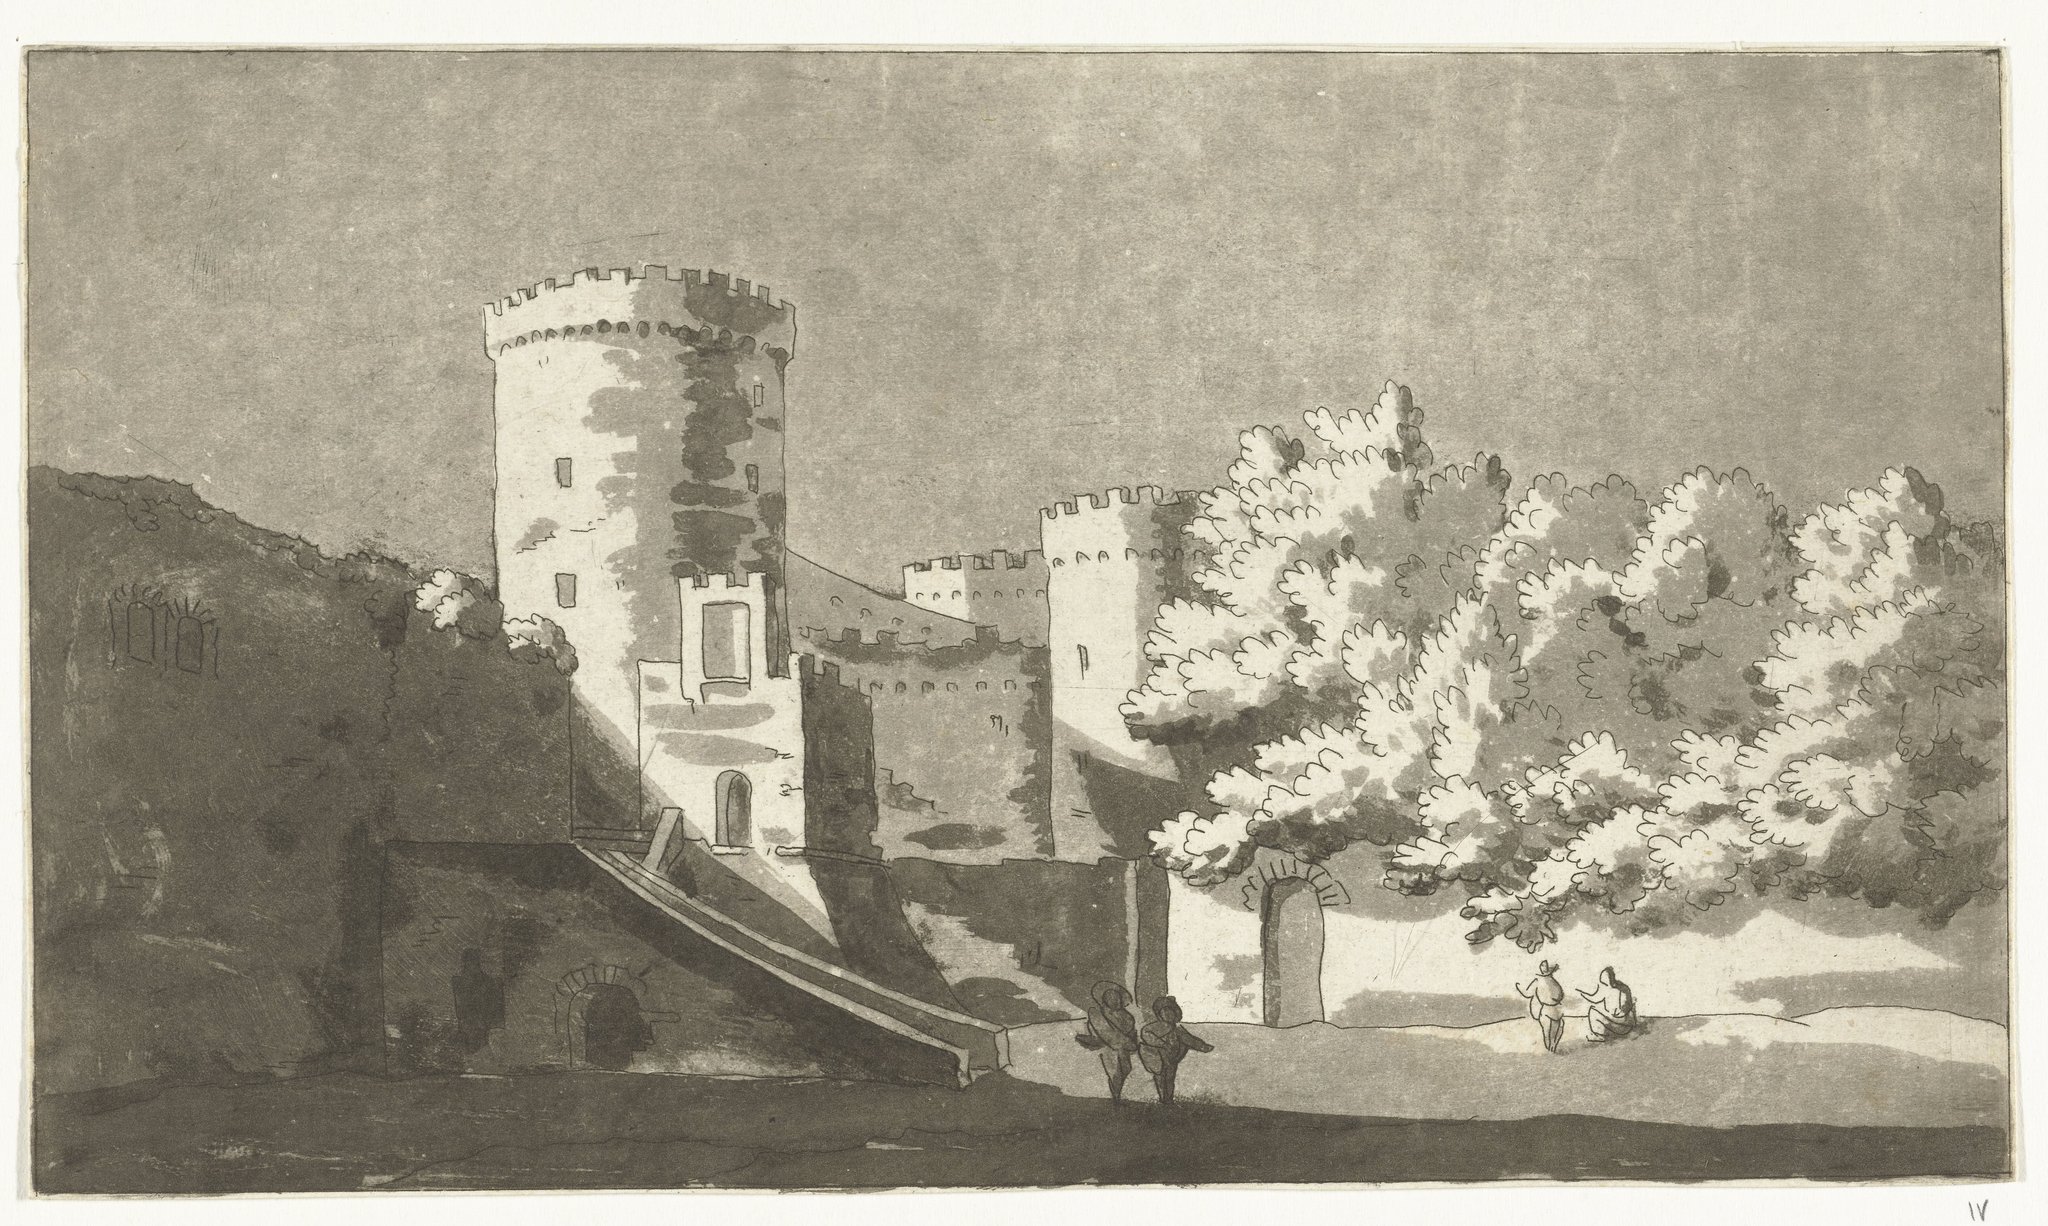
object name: print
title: Casteel Gandolfo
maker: anthonie van den bos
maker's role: draughtsman, print maker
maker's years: 1763-1838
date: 1778-1838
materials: paper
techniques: aquatint, etching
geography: netherlands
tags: castle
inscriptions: collector's mark: Lugt 2228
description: Naar een tekening in Parijs, Fondation Custodia (coll. F. Lugt), Parijs, inv.nr. 6481, fol. 11, met het opschrift 'Castel Gandolfo'.